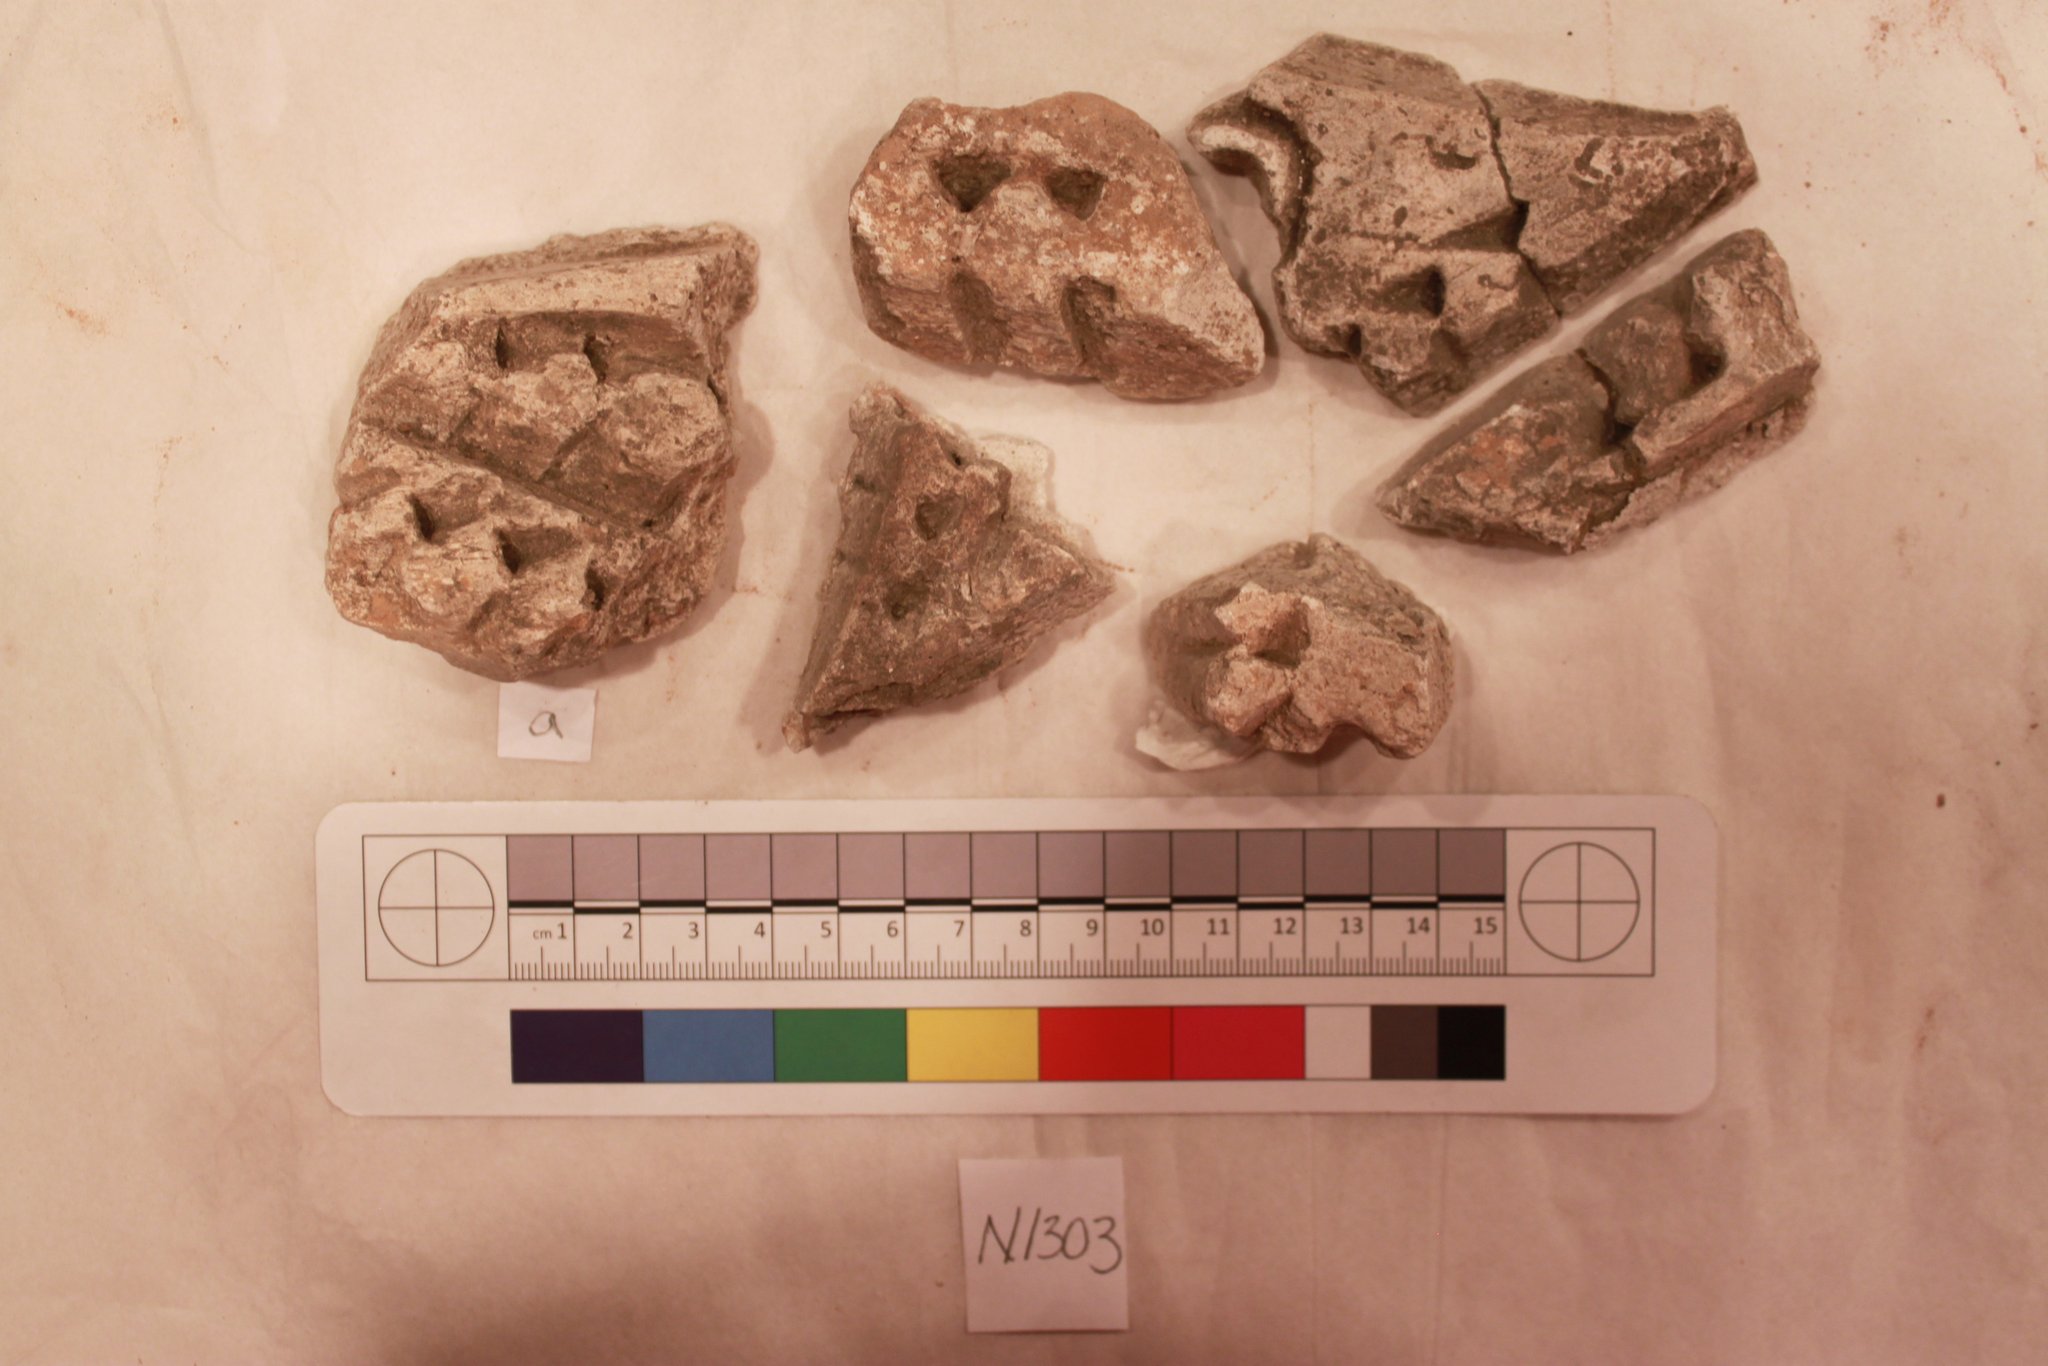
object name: fragment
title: Stucco Fragment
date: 701-1200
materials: plaster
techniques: carving, painting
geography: iran